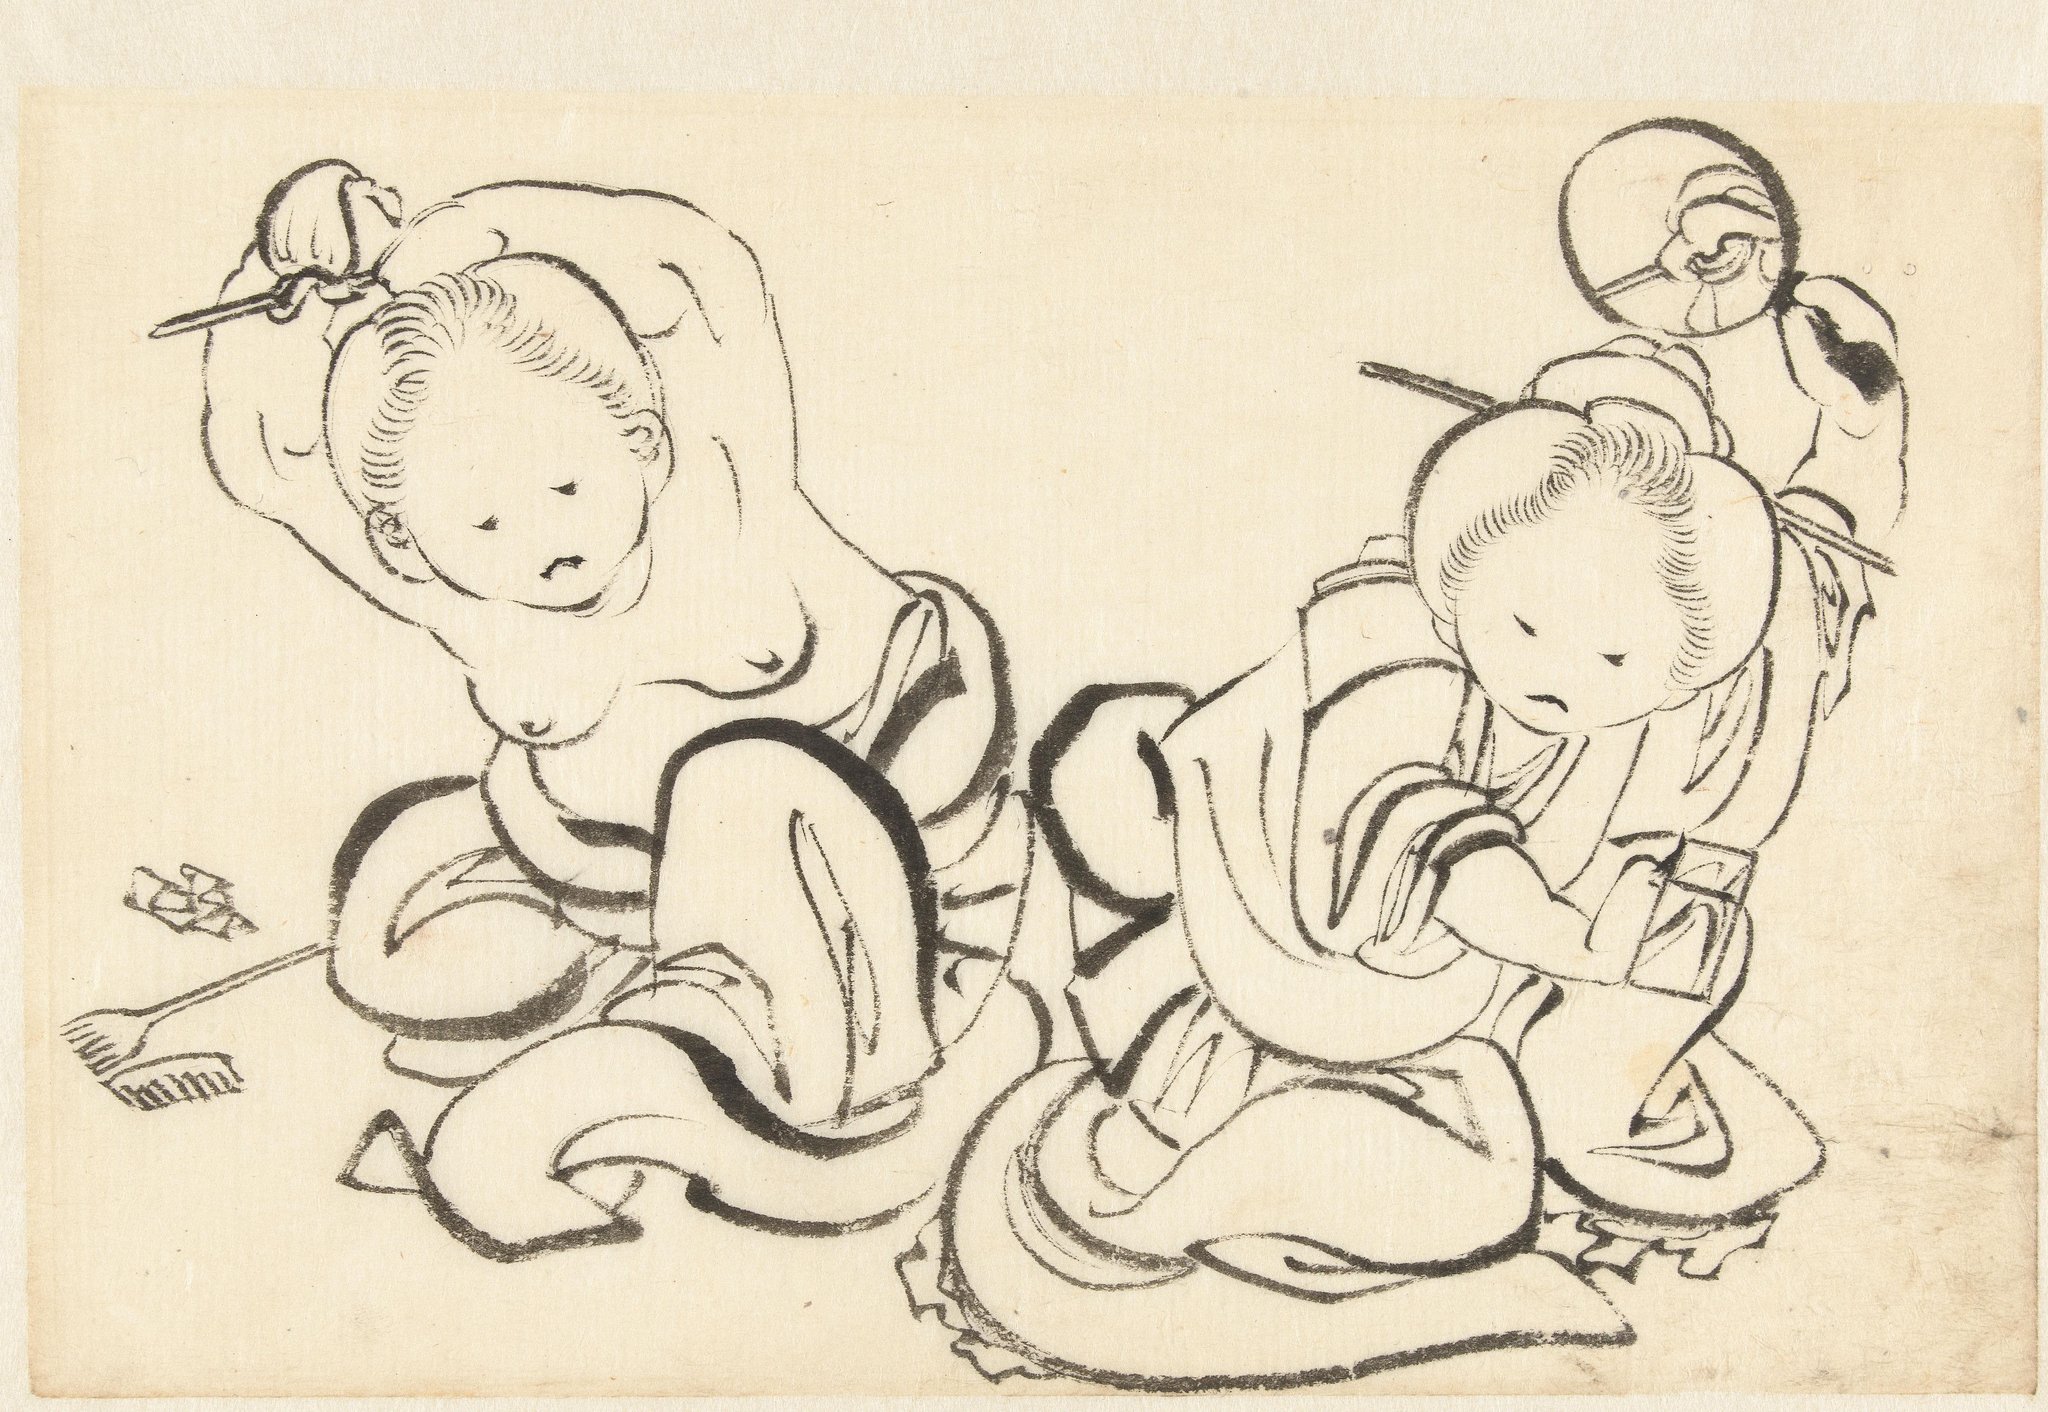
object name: drawing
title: Twee vrouwen die zich kappen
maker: katsushika hokusai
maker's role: draughtsman, print maker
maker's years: 1760-1849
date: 1780-1849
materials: paper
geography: japan